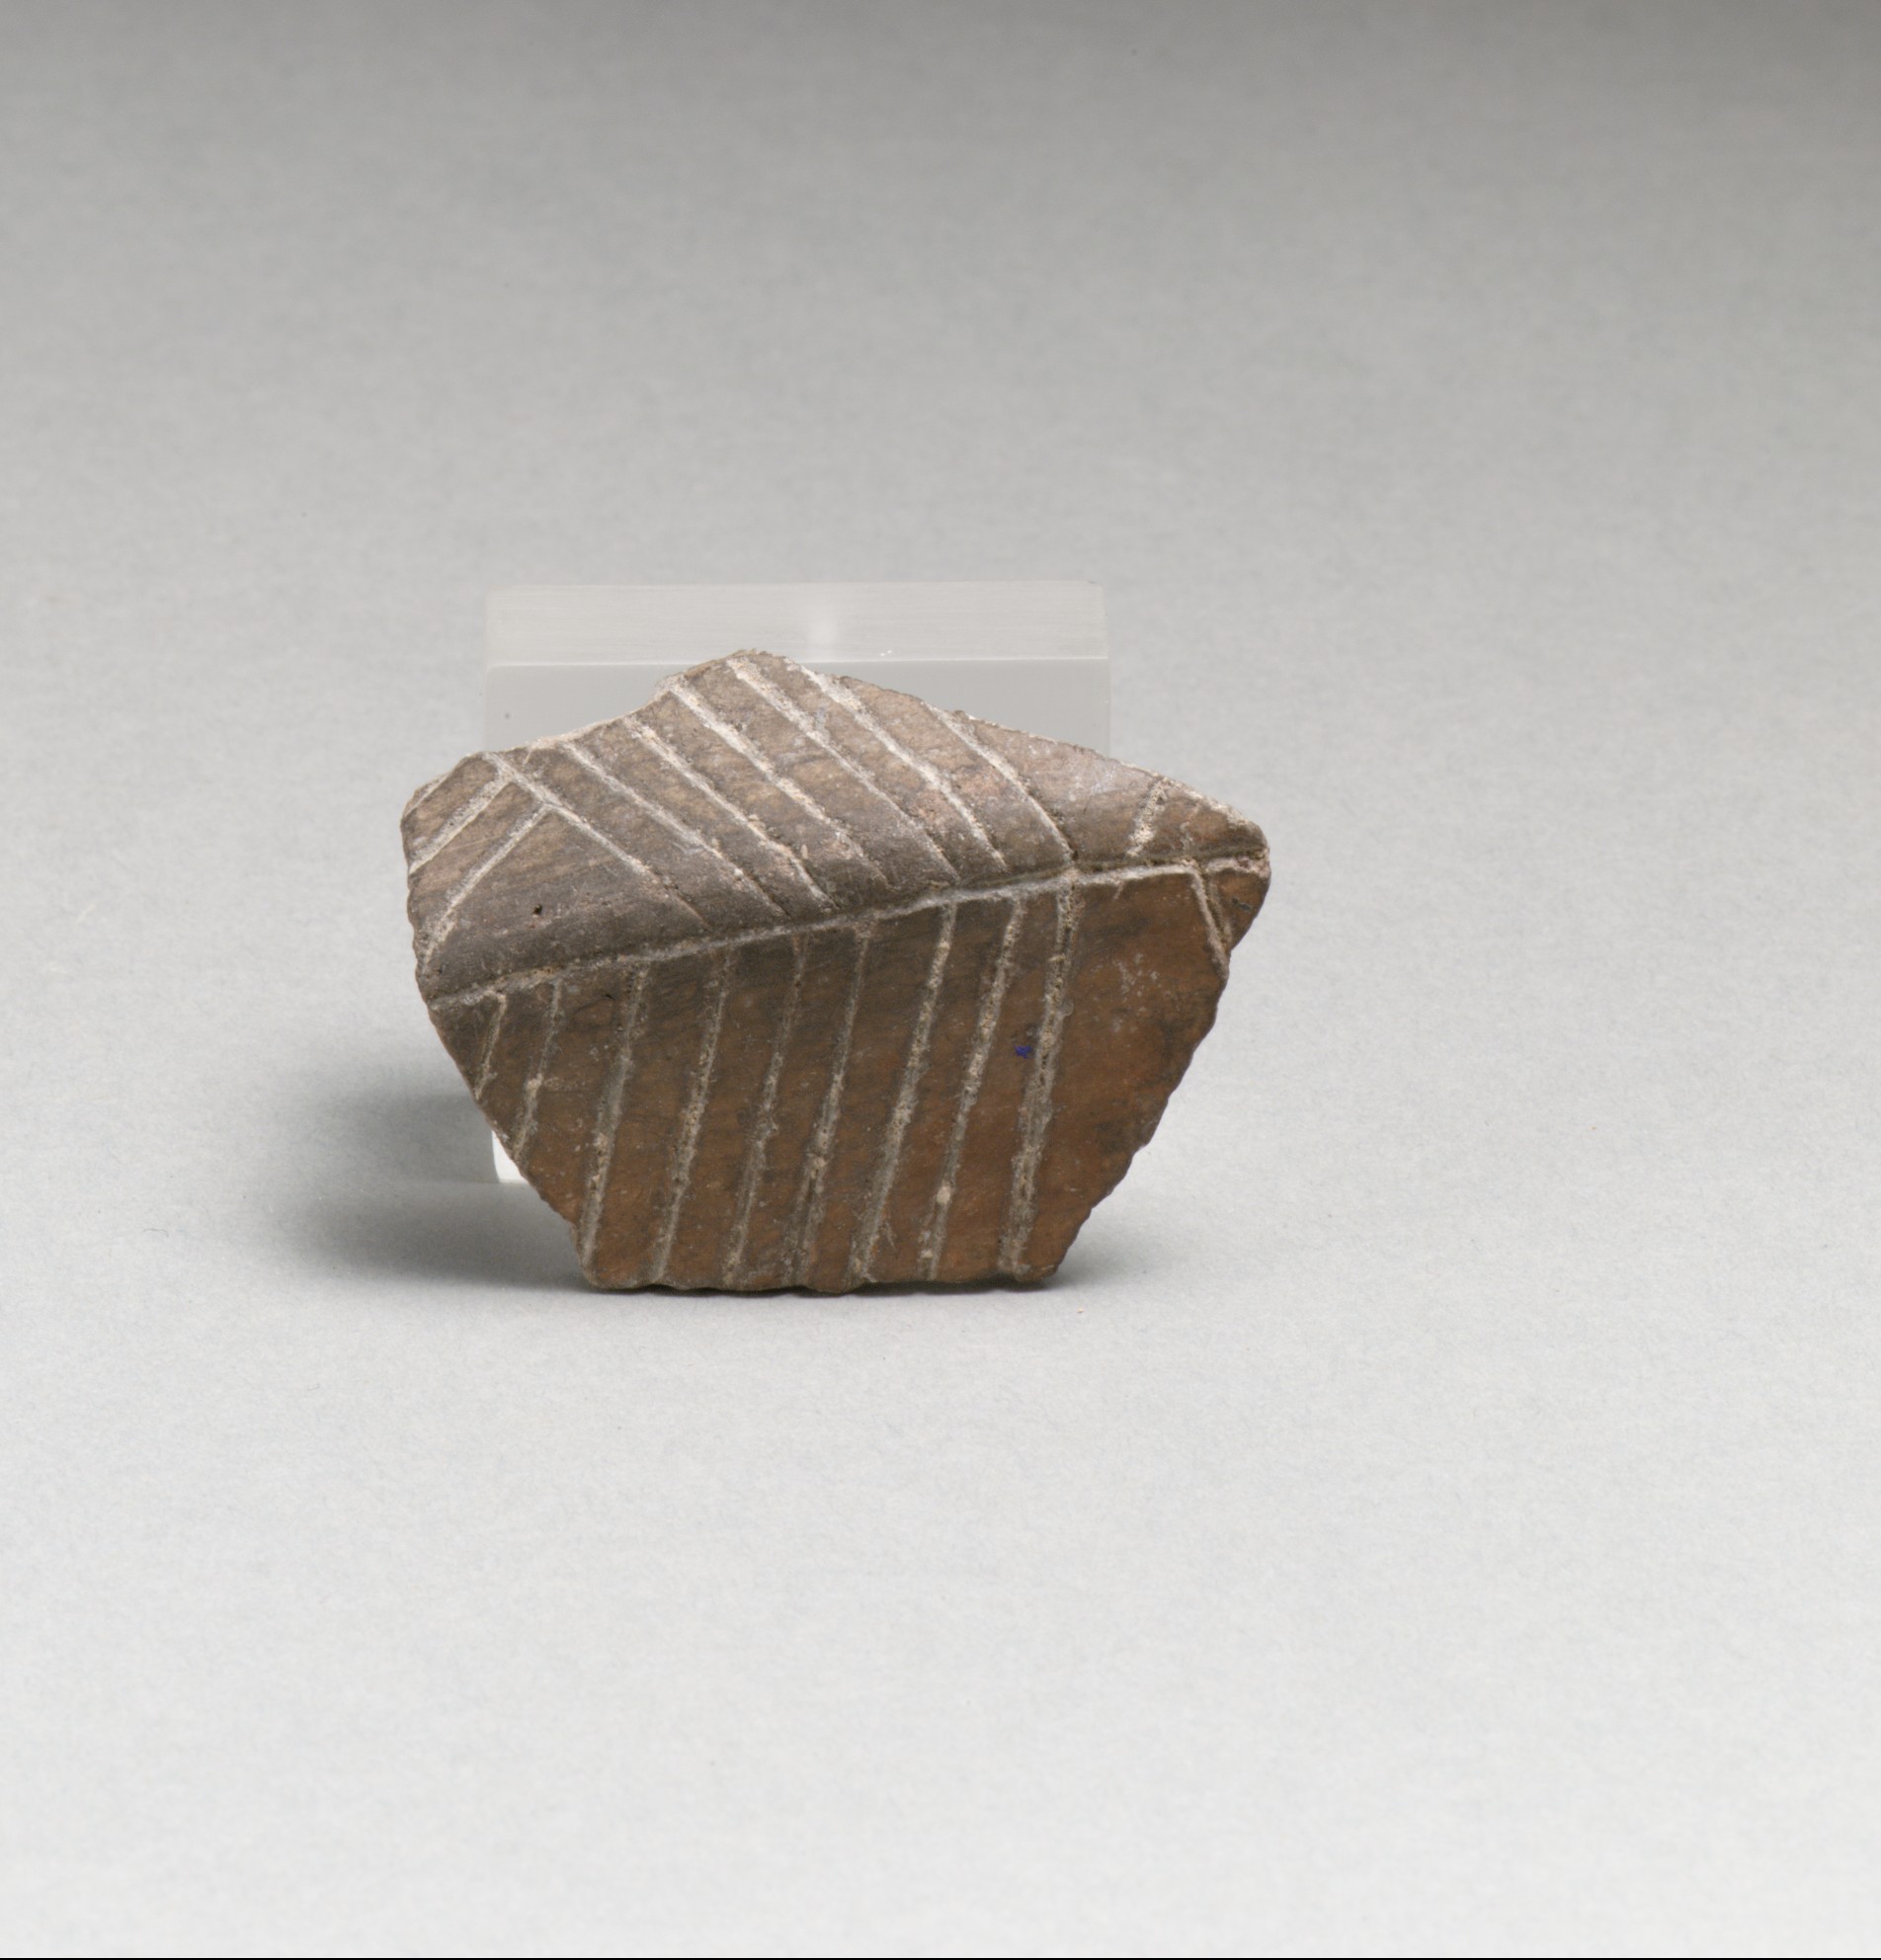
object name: vase fragment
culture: aegean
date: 7000-3000 BCE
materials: terracotta